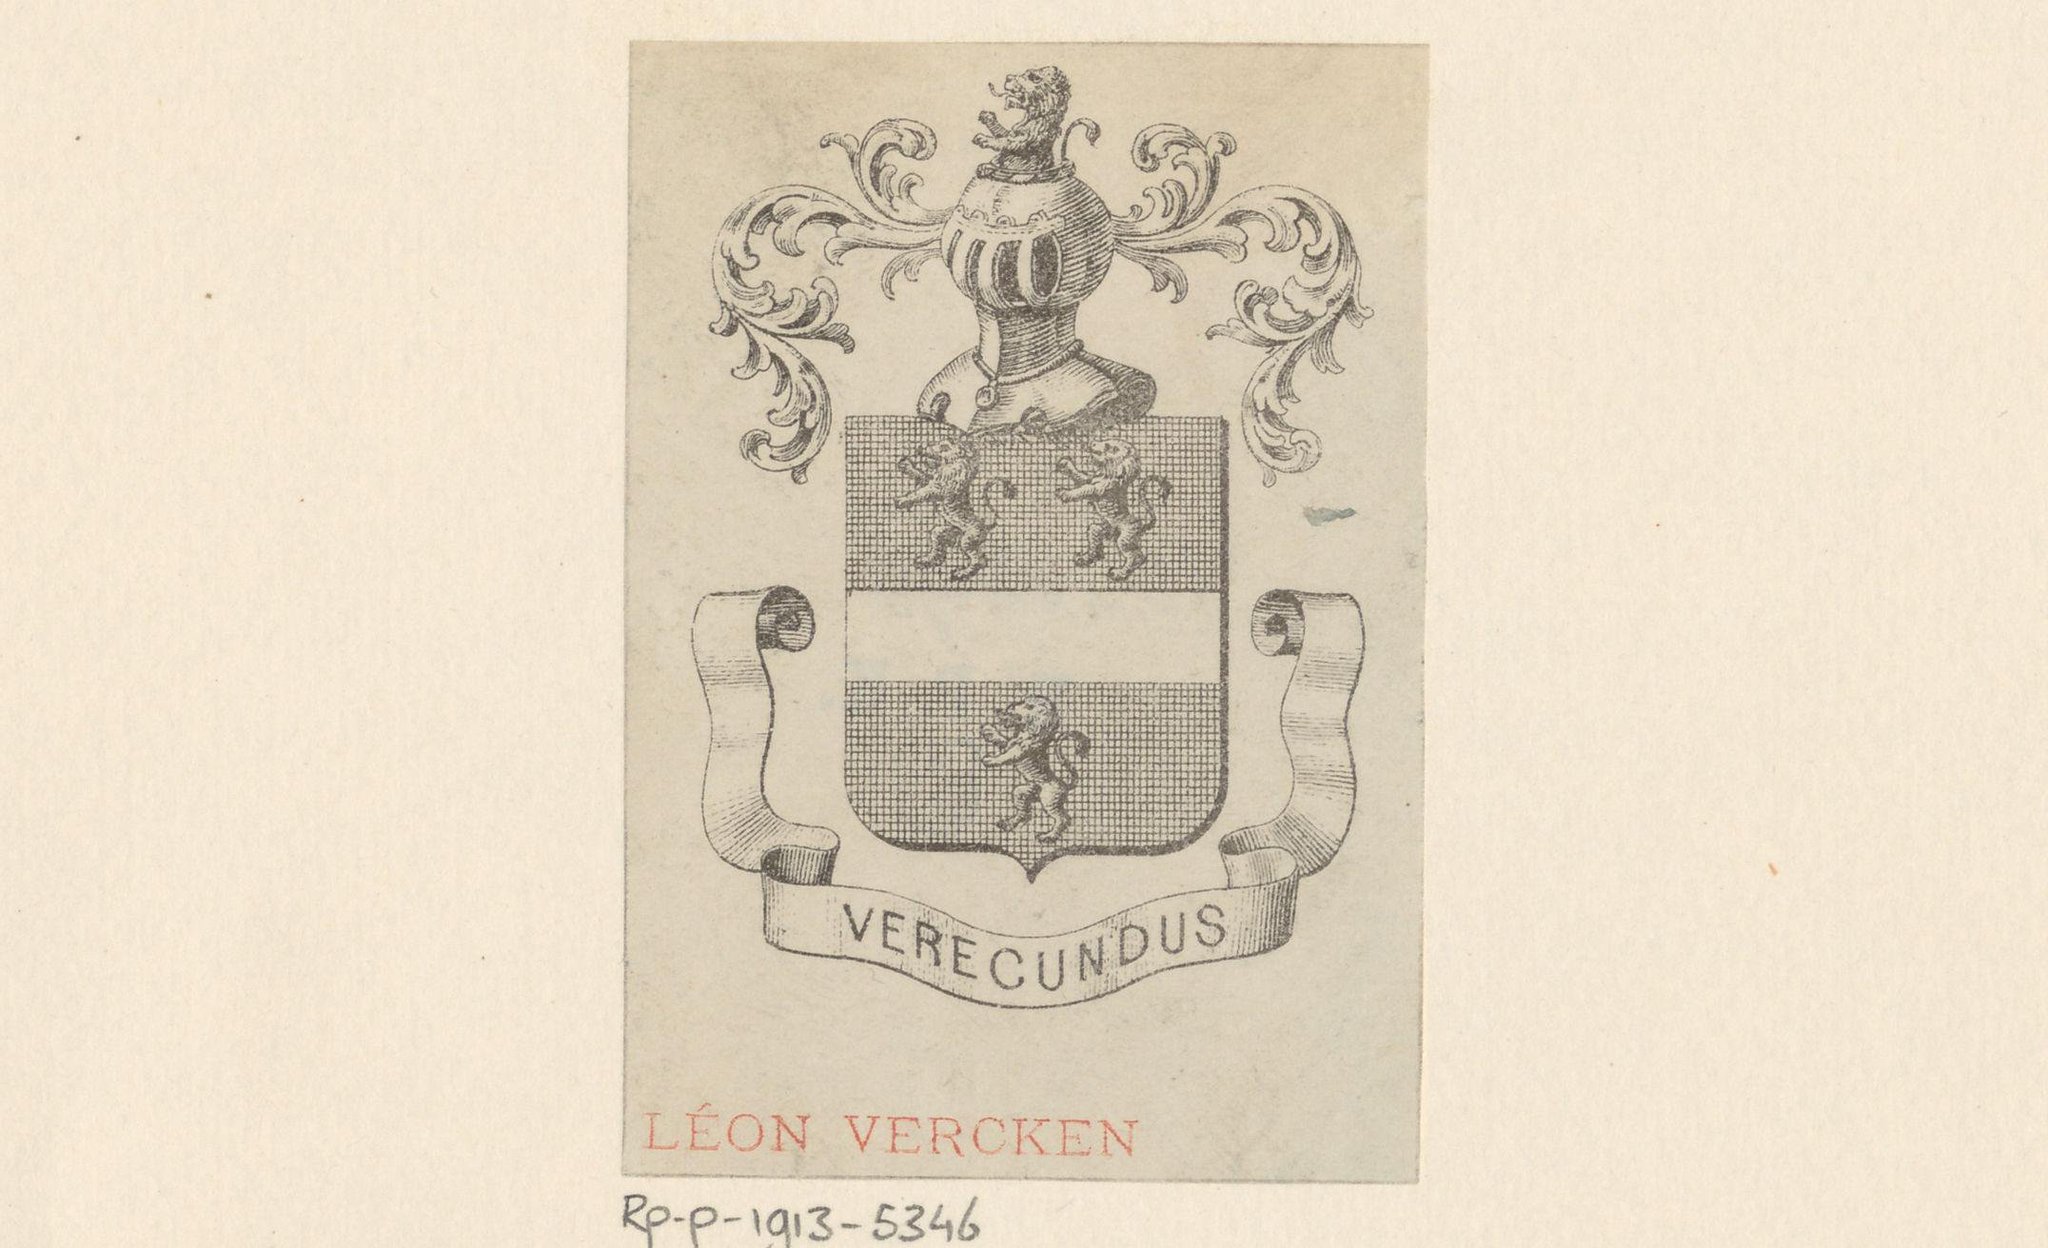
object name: bookplate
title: Verecundus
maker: Anonymous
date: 1838-1892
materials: paper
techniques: etching, relief print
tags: armorial bearing, heraldry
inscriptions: collector's mark: Lugt 2233, collector's mark: Lugt 2760